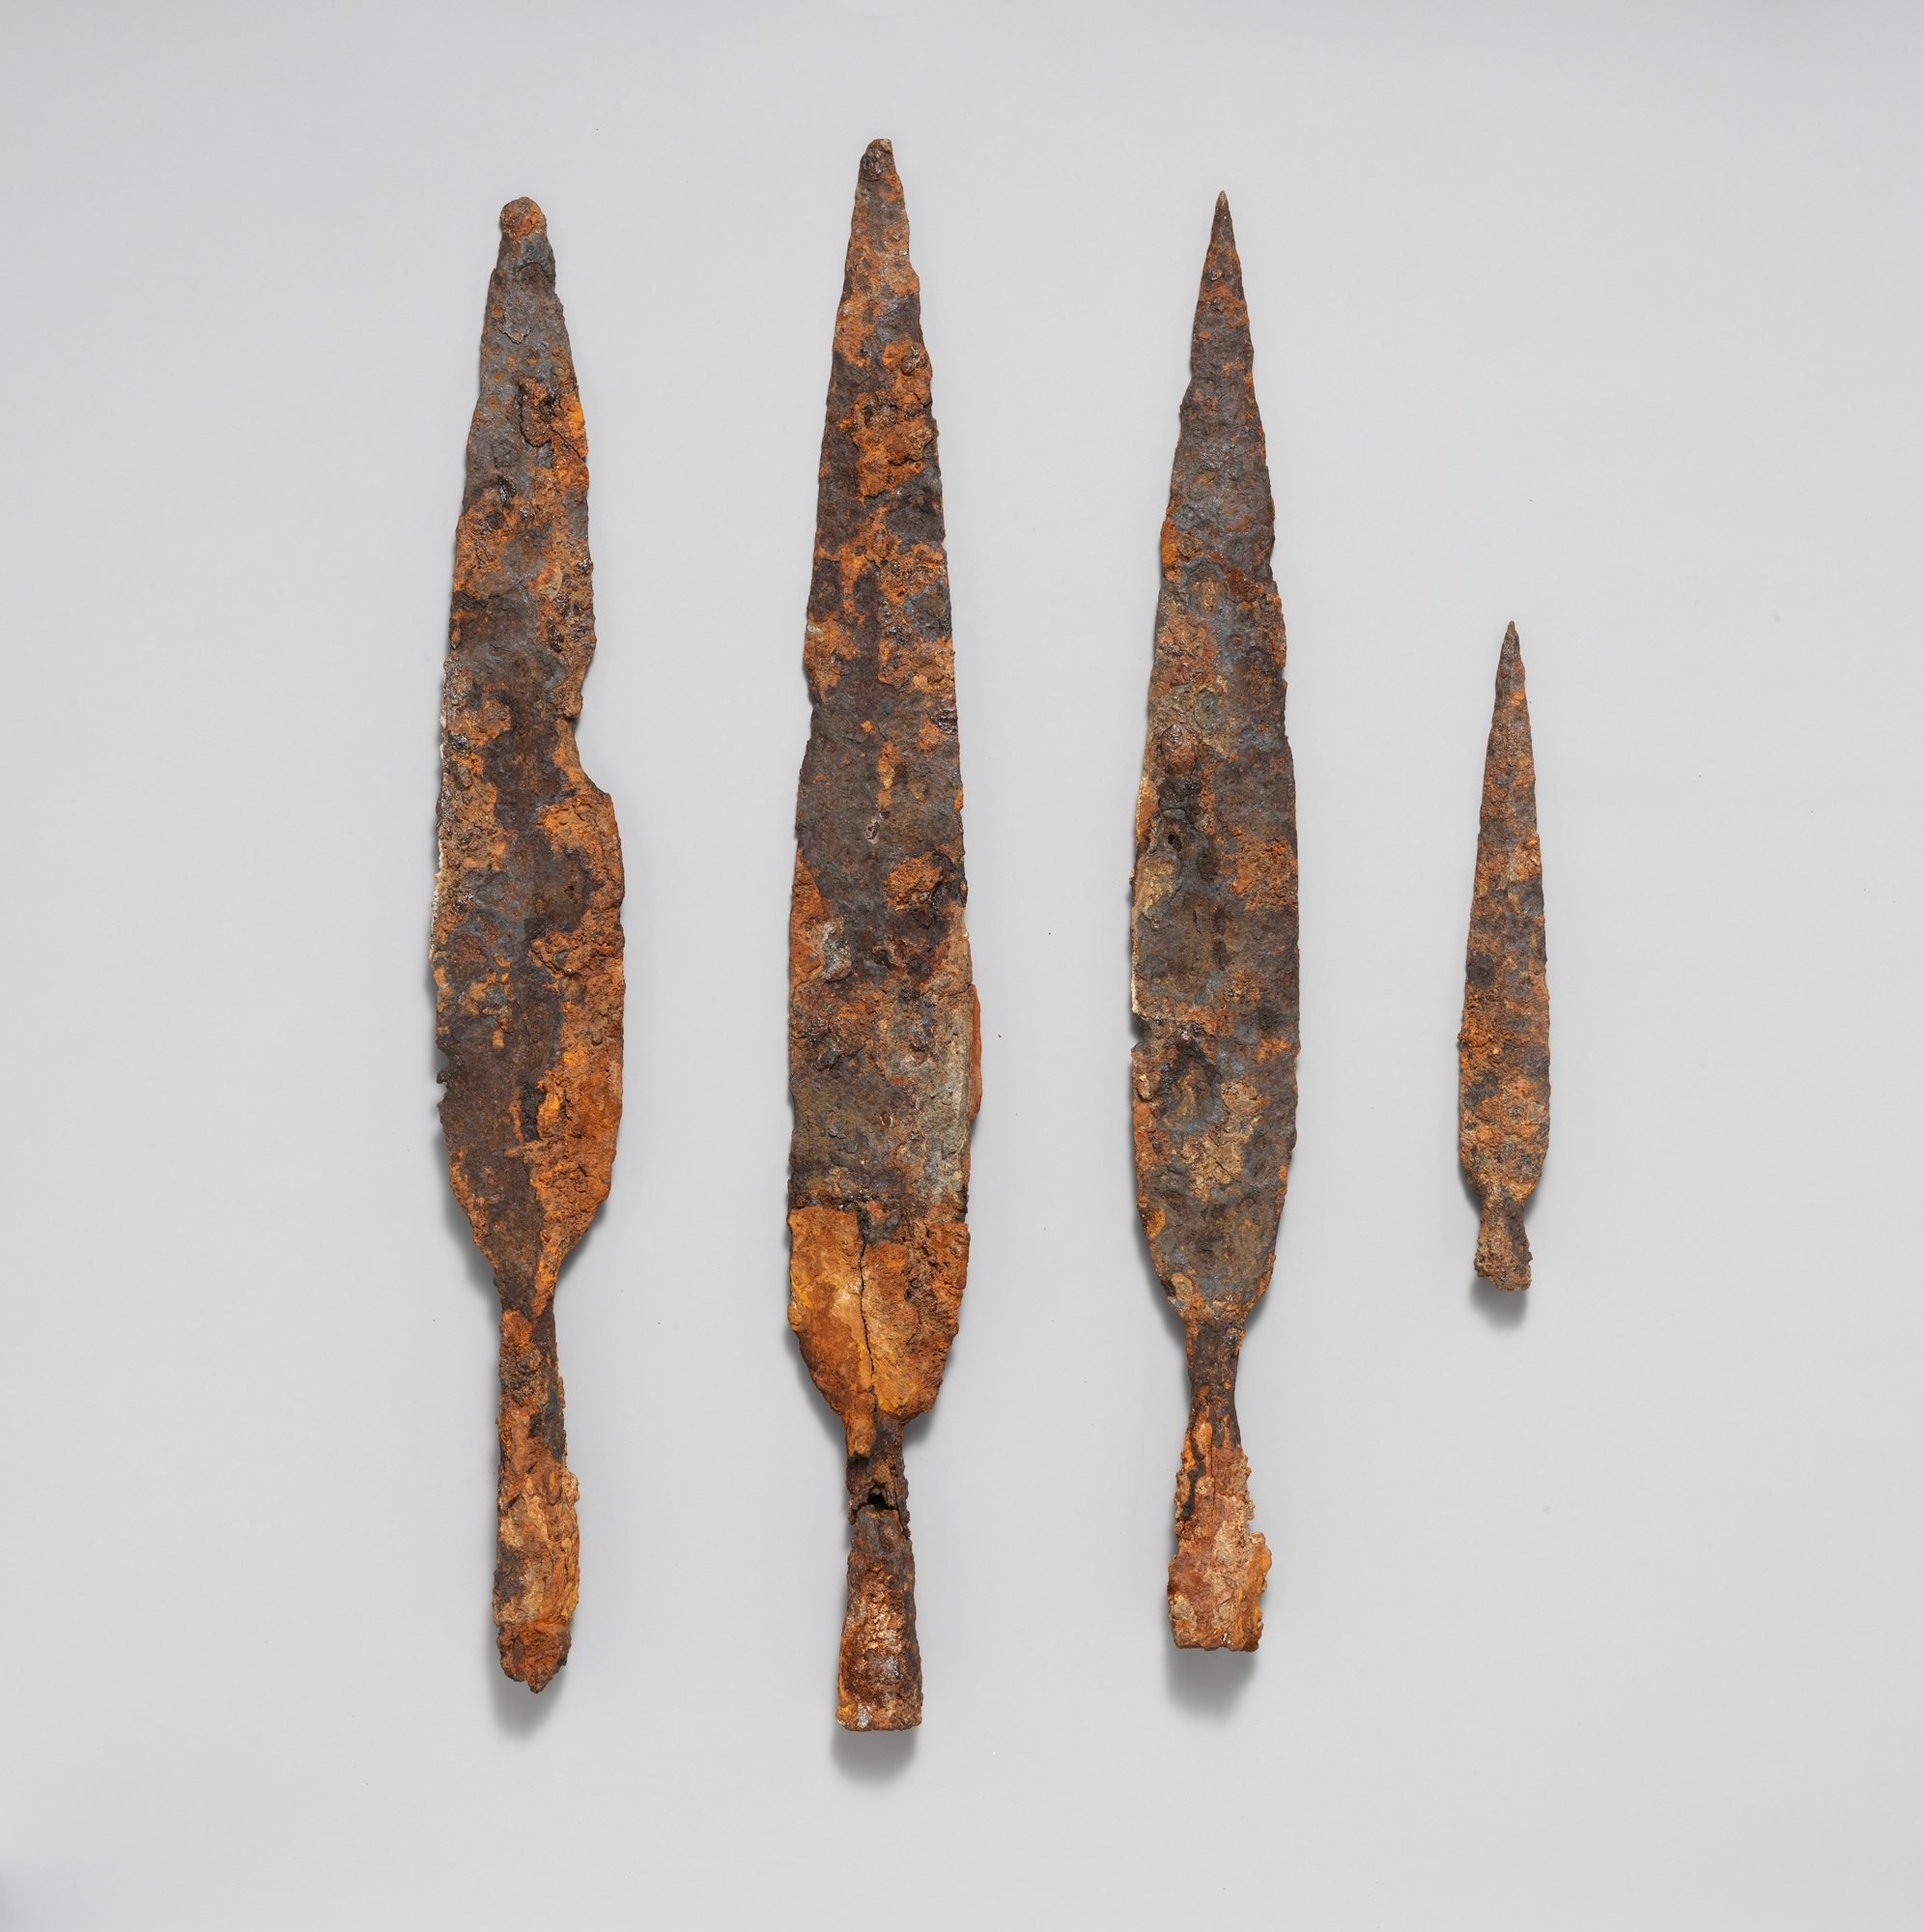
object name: spearhead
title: Four iron spearheads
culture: etruscan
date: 550 BCE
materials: iron